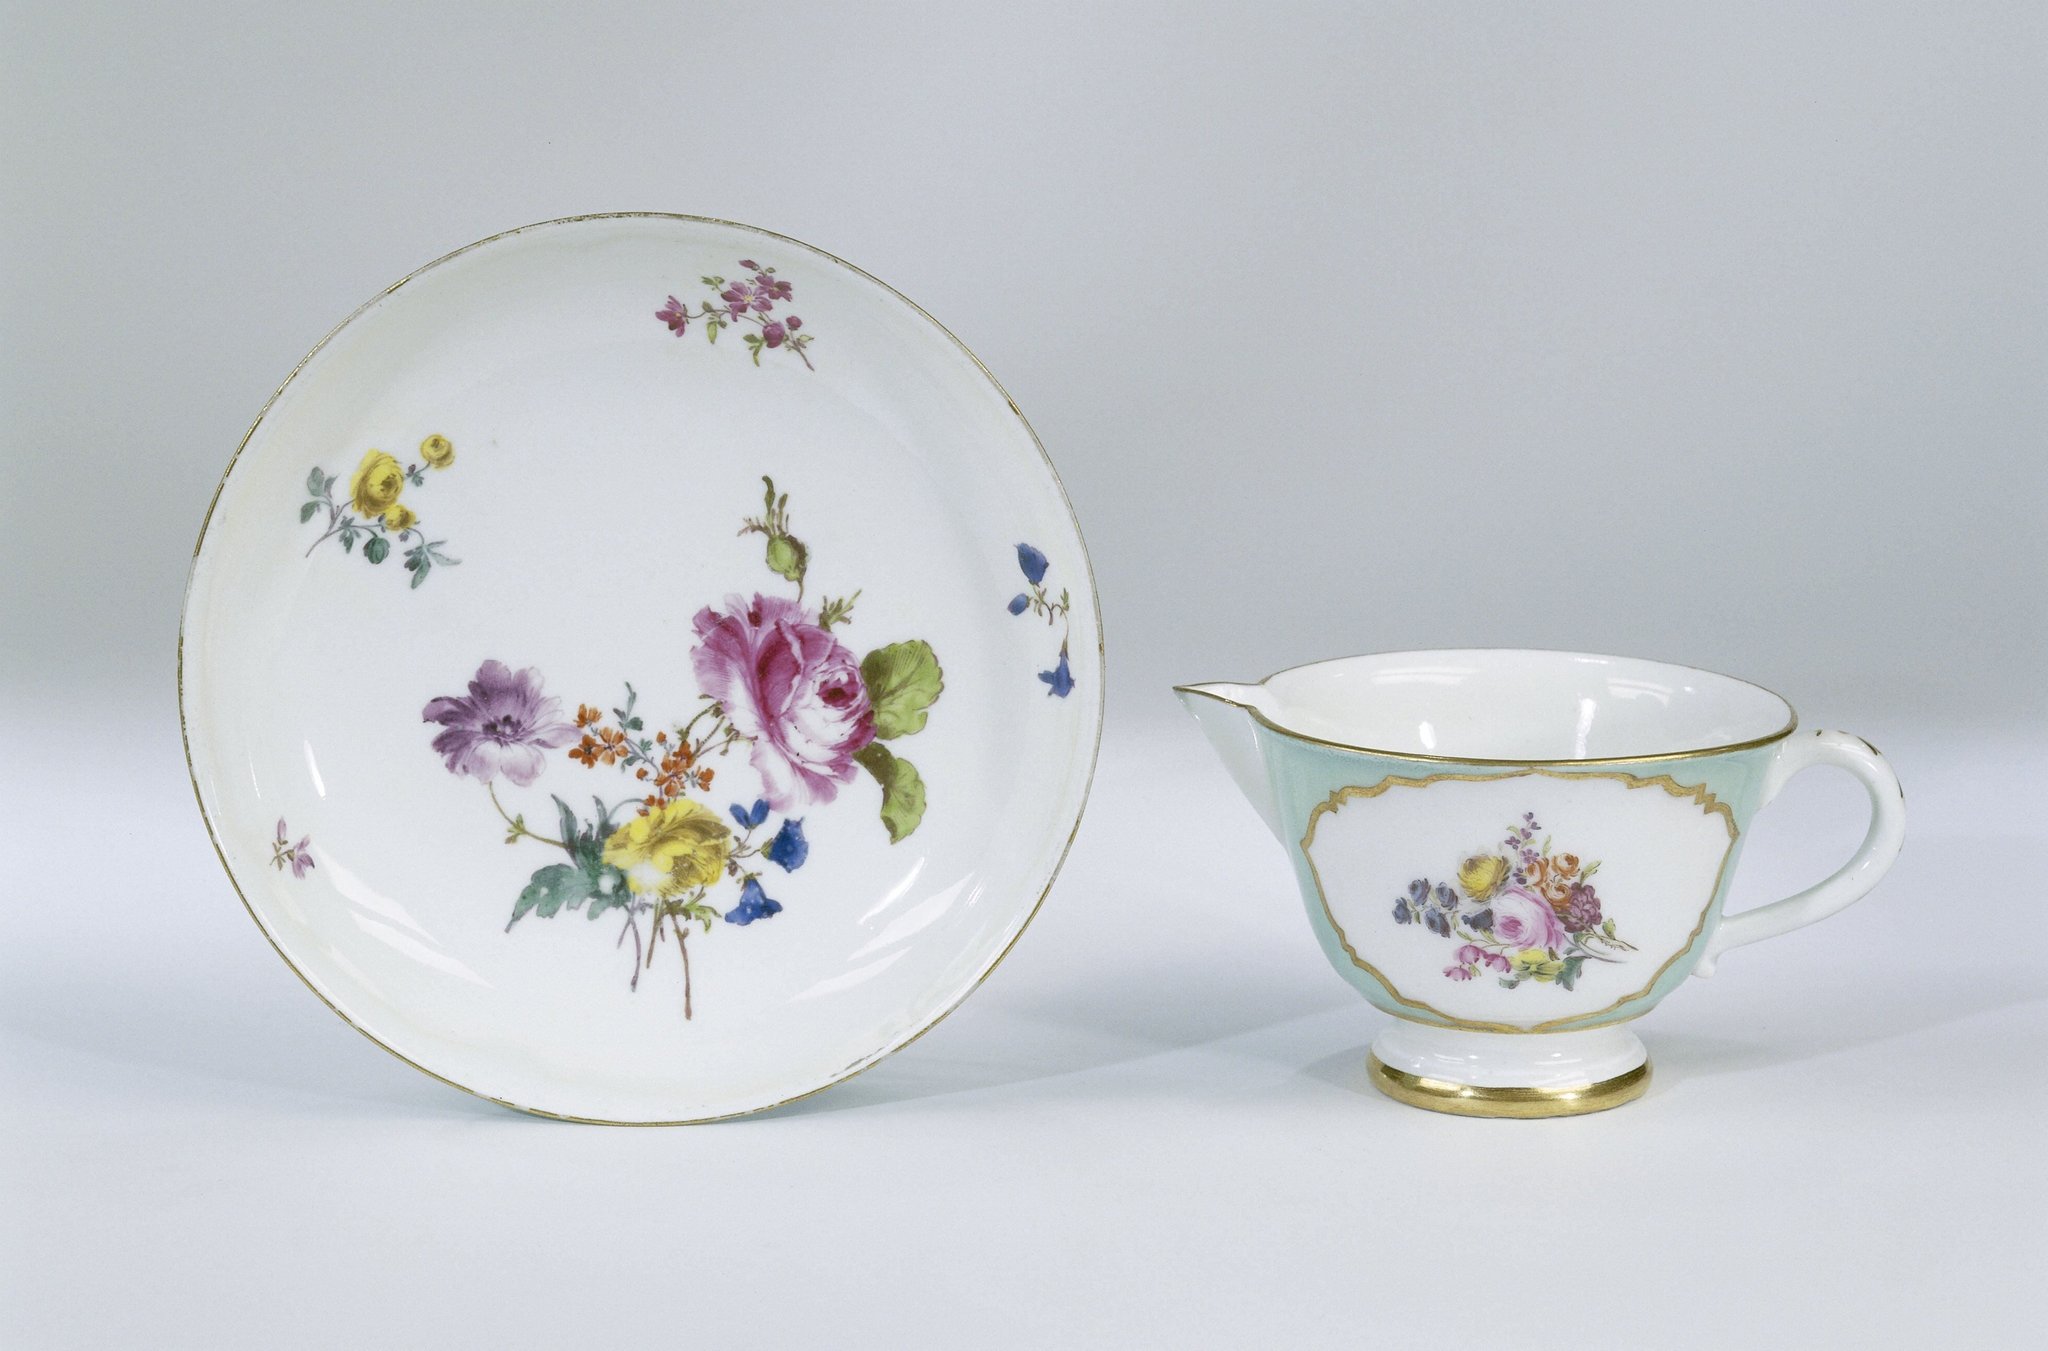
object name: eating drinking utensil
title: Kop, veelkleurig beschilderd met bloemboeketten in uitgespaarde vierpassen in een turkooise fond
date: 1750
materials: porcelain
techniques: painted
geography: meissen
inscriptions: factory mark, mold mark: ‘17’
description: Kop van beschilderd porselein. De halfbolvormige kop staat op een voet, heeft een tuit en een C-vormig oor. De kop heeft een turkooise fond waarin twee uitgespaarde cartouches waarbinnen veelkleurige bloemboeketten. De kop is gemerkt.